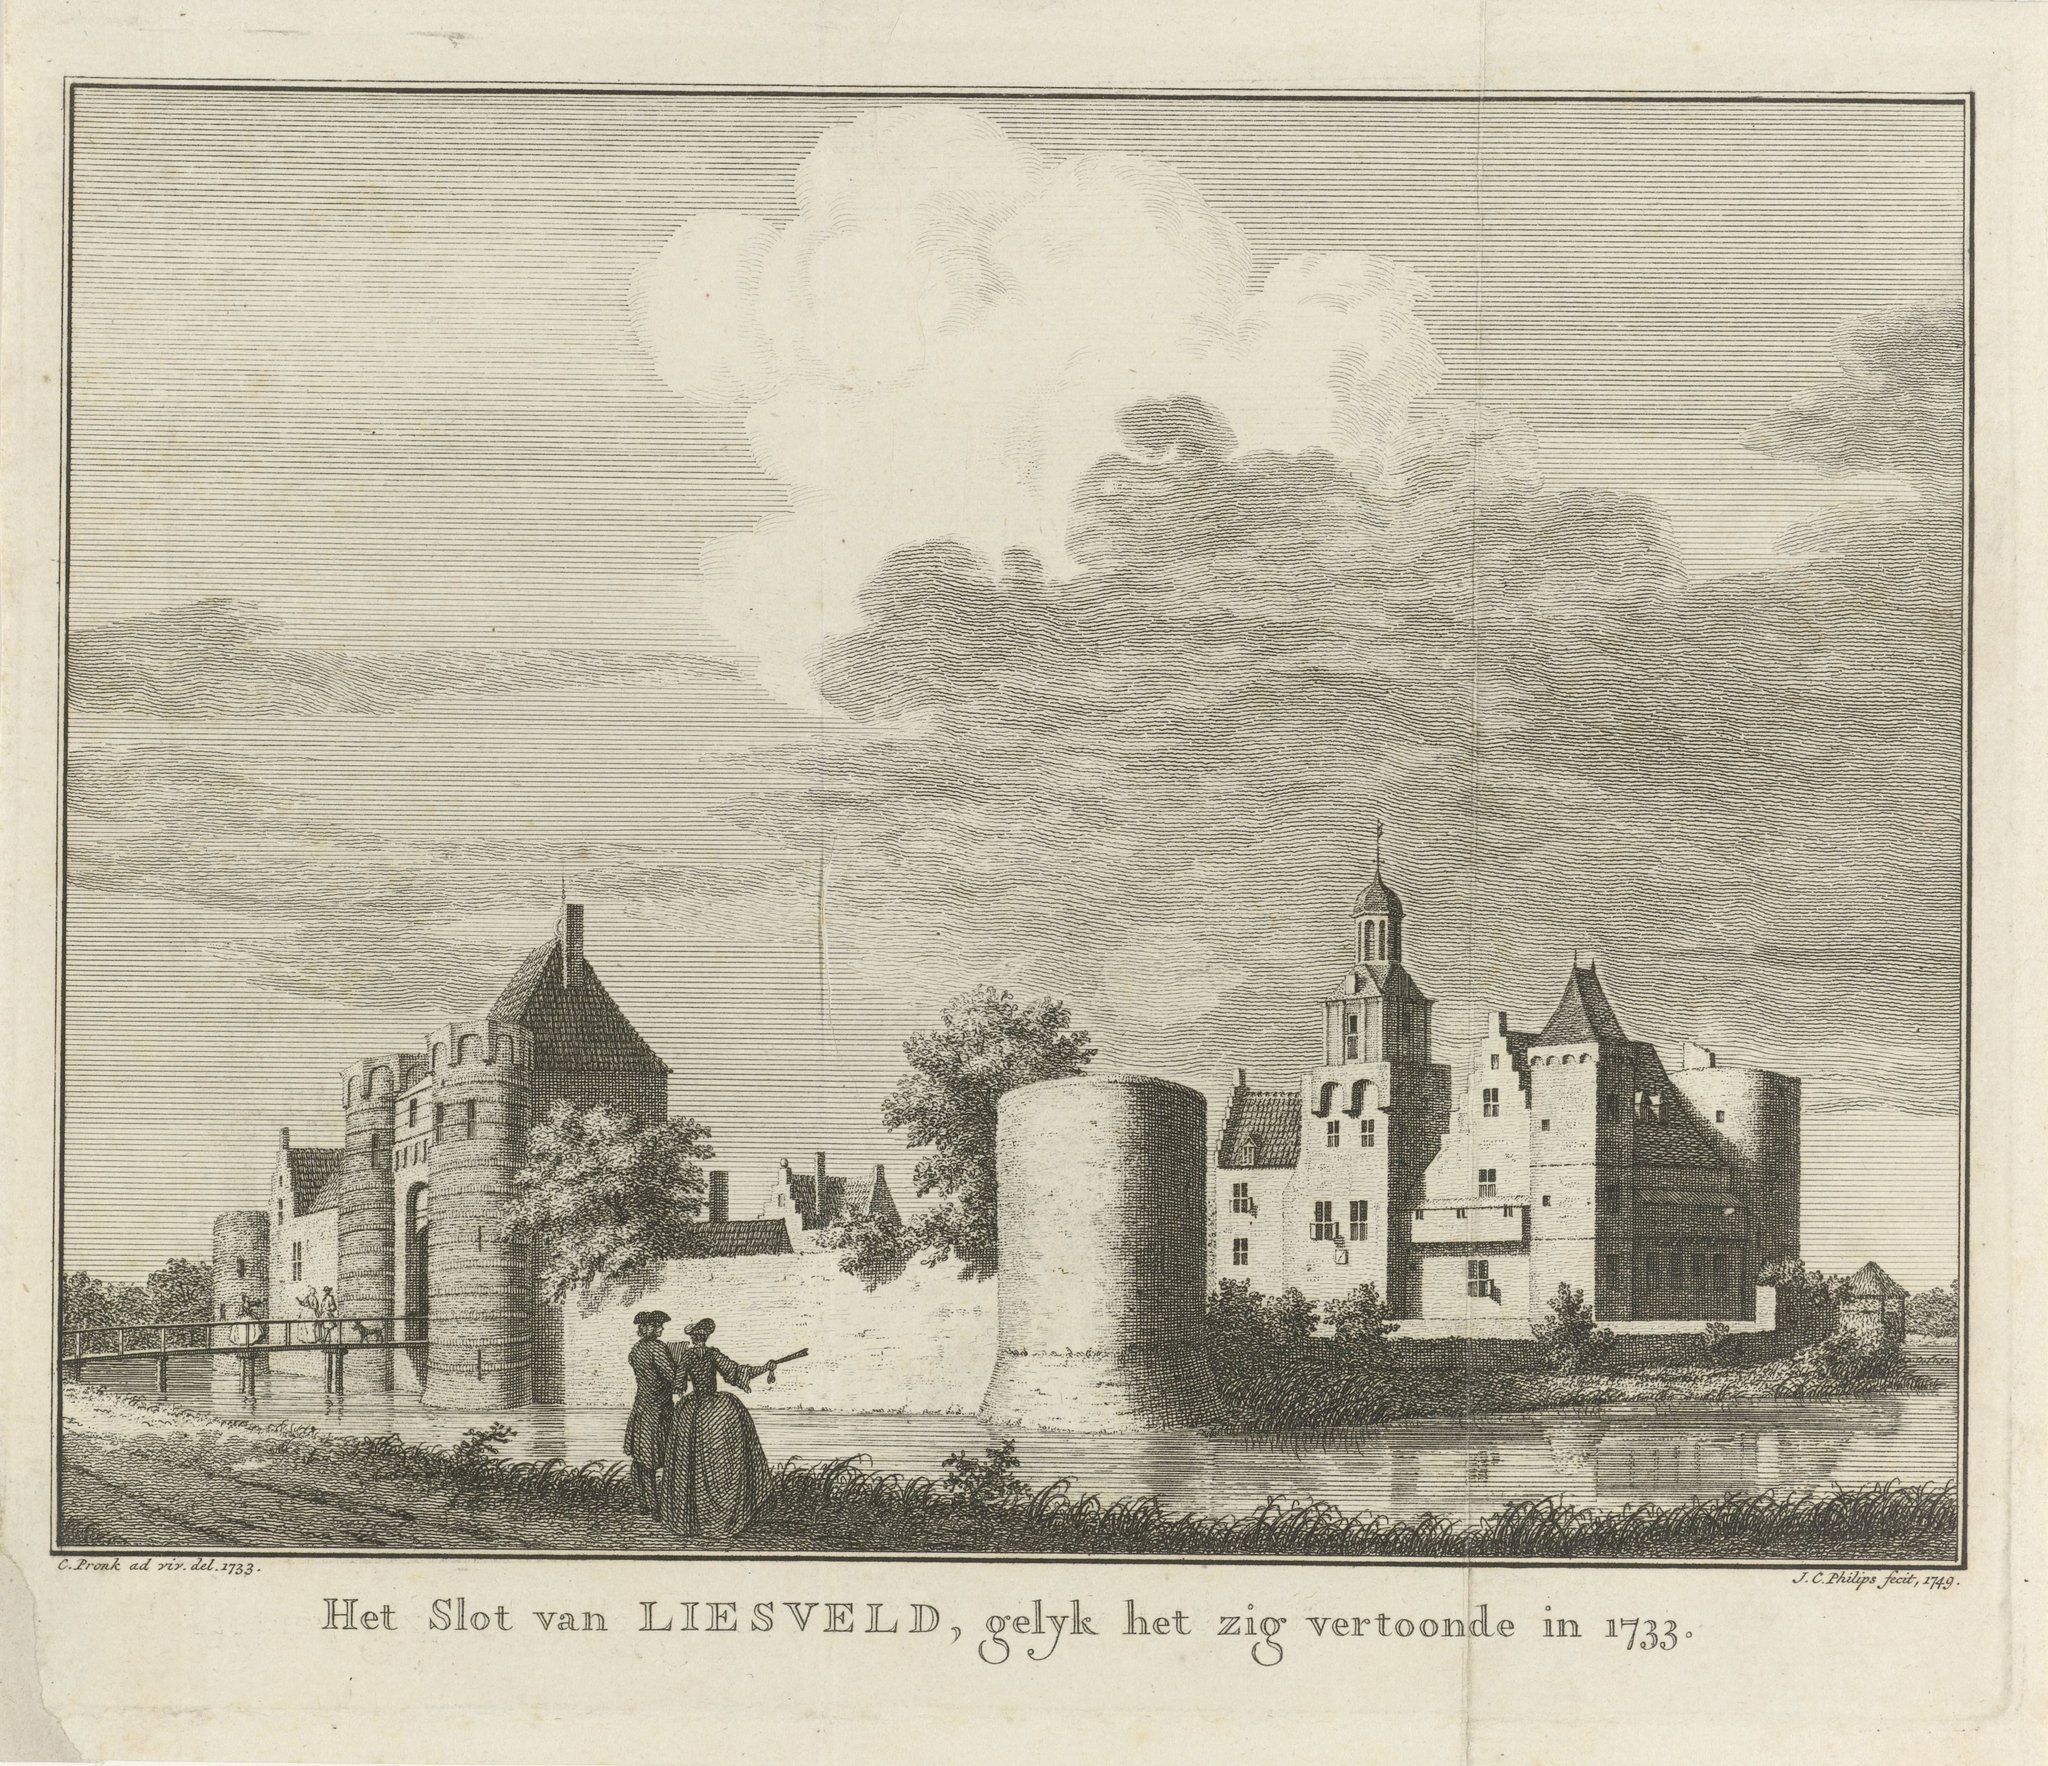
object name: book illustration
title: Het Slot van Liesveld, gelyk het zig vertoonde in 1733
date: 1749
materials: paper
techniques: etching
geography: amsterdam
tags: castle, bridge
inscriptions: collector's mark: Lugt 2228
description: Gezicht op Kasteel Liesveld bij Groot-Ammers in de Alblasserwaard, in de situatie omstreeks 1733.